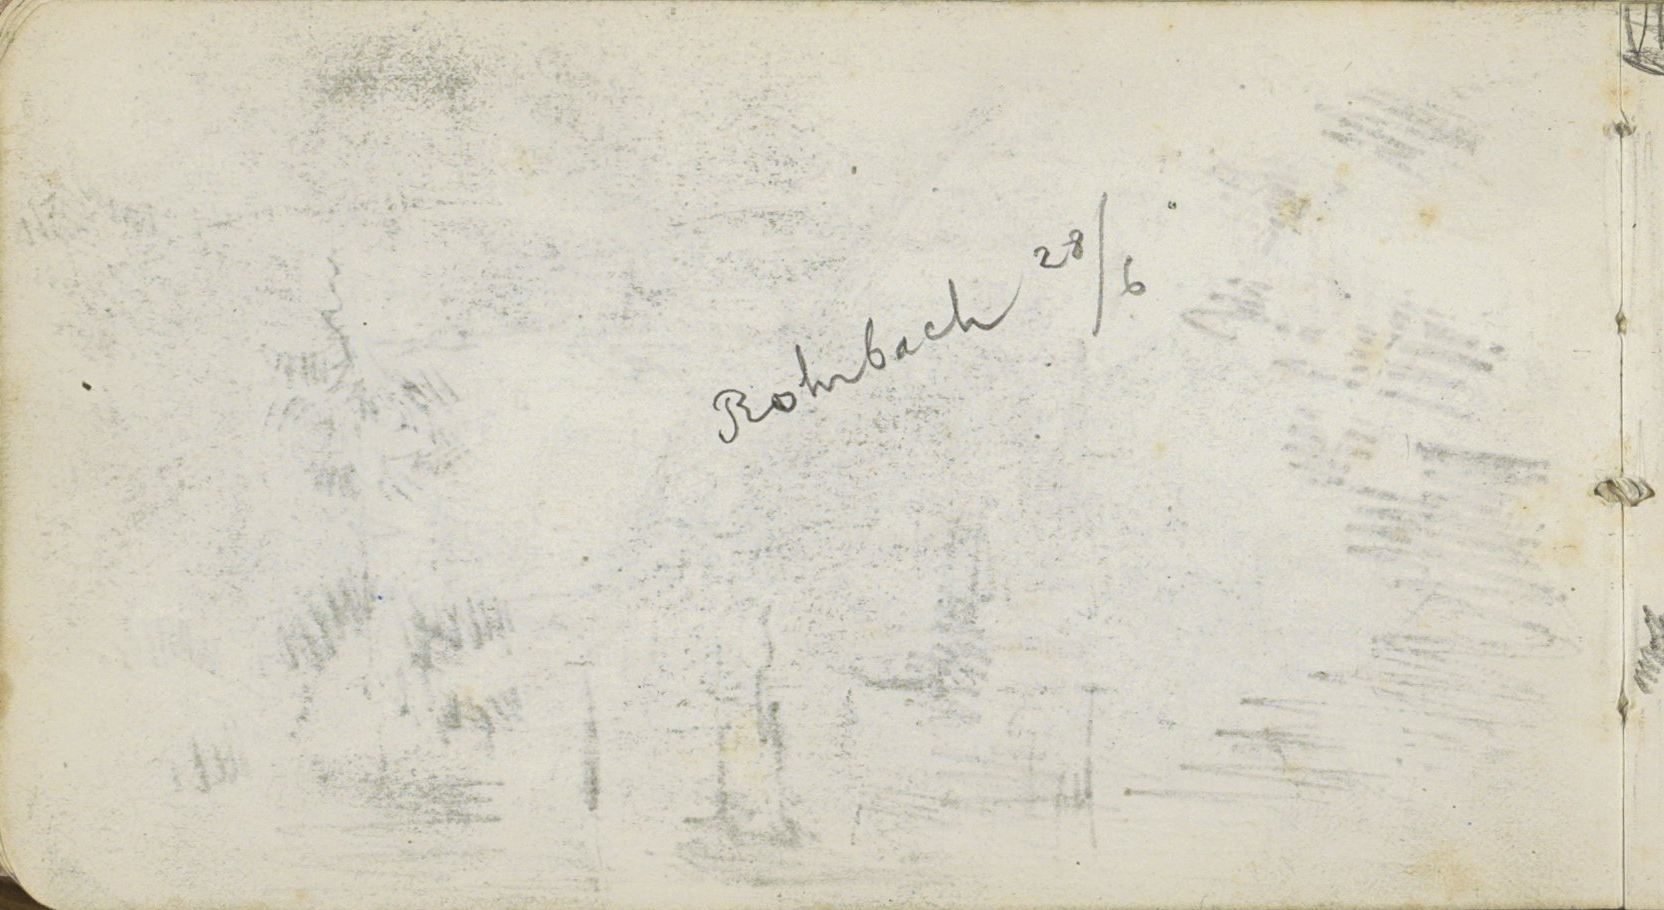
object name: sketchbook leaf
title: Notitie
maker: geo poggenbeek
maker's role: draughtsman, painter, print maker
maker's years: 1853-1903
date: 1806-1876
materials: paper, pencil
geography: rohrbach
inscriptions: date and inscription: ‘Rohrnbach 28-6’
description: Blad 3 verso uit een schetsboek met 69 bladen.